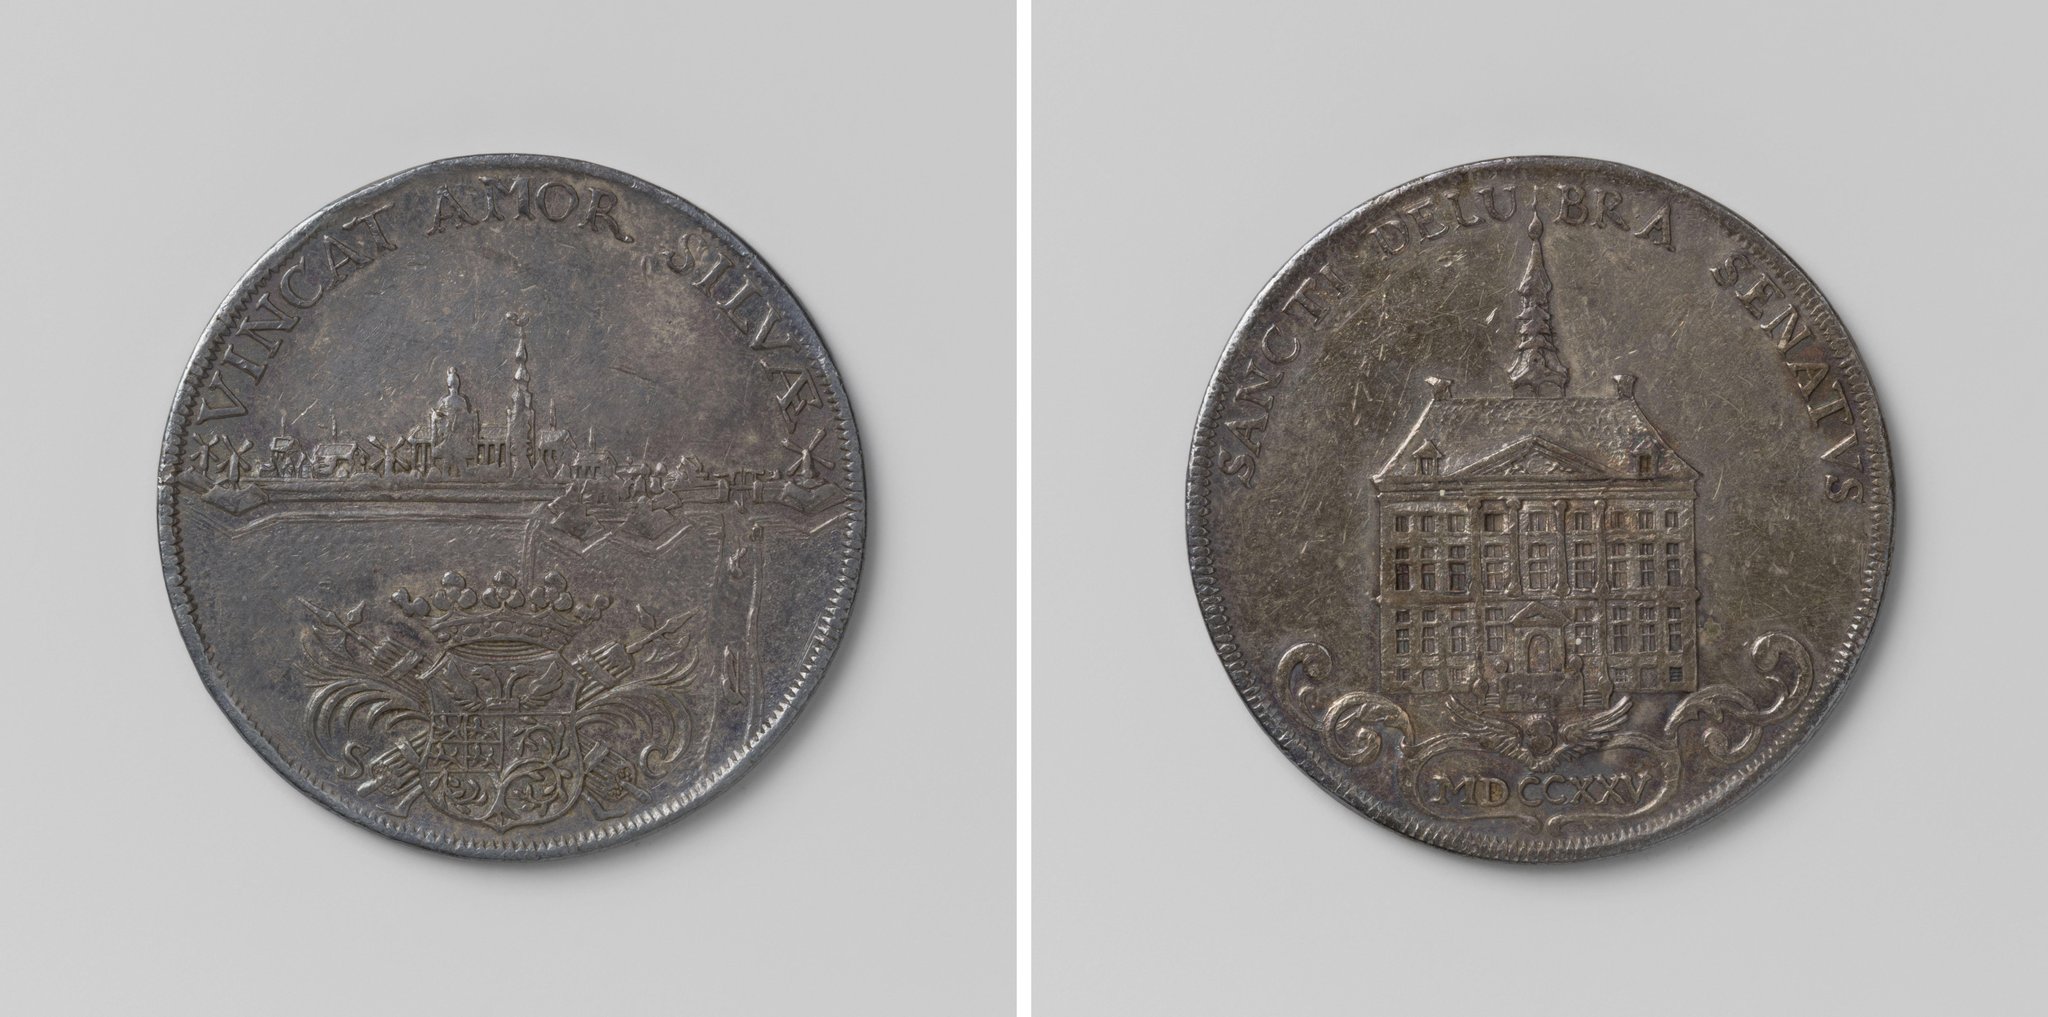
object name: council medal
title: Vroedschapspenning van de stad 's-Hertogenbosch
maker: theodorus casparus van berckel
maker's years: 1680-1734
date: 1725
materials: silver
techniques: striking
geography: den bosch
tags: den bosch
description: Zilveren penning. Voorzijde: gezicht op stad vanaf de noordzijde en de Dieze met twee scheepjes; op voorgrond: gekroond wapenschild op twee gekruiste roedebundels met bijlen en twee palmtakken tussen monogram van de letters S en C binnen omschrift. Keerzijde: stadhuis boven cartouche met jaartal onder gevleugeld engelenkopje binnen omschrift.